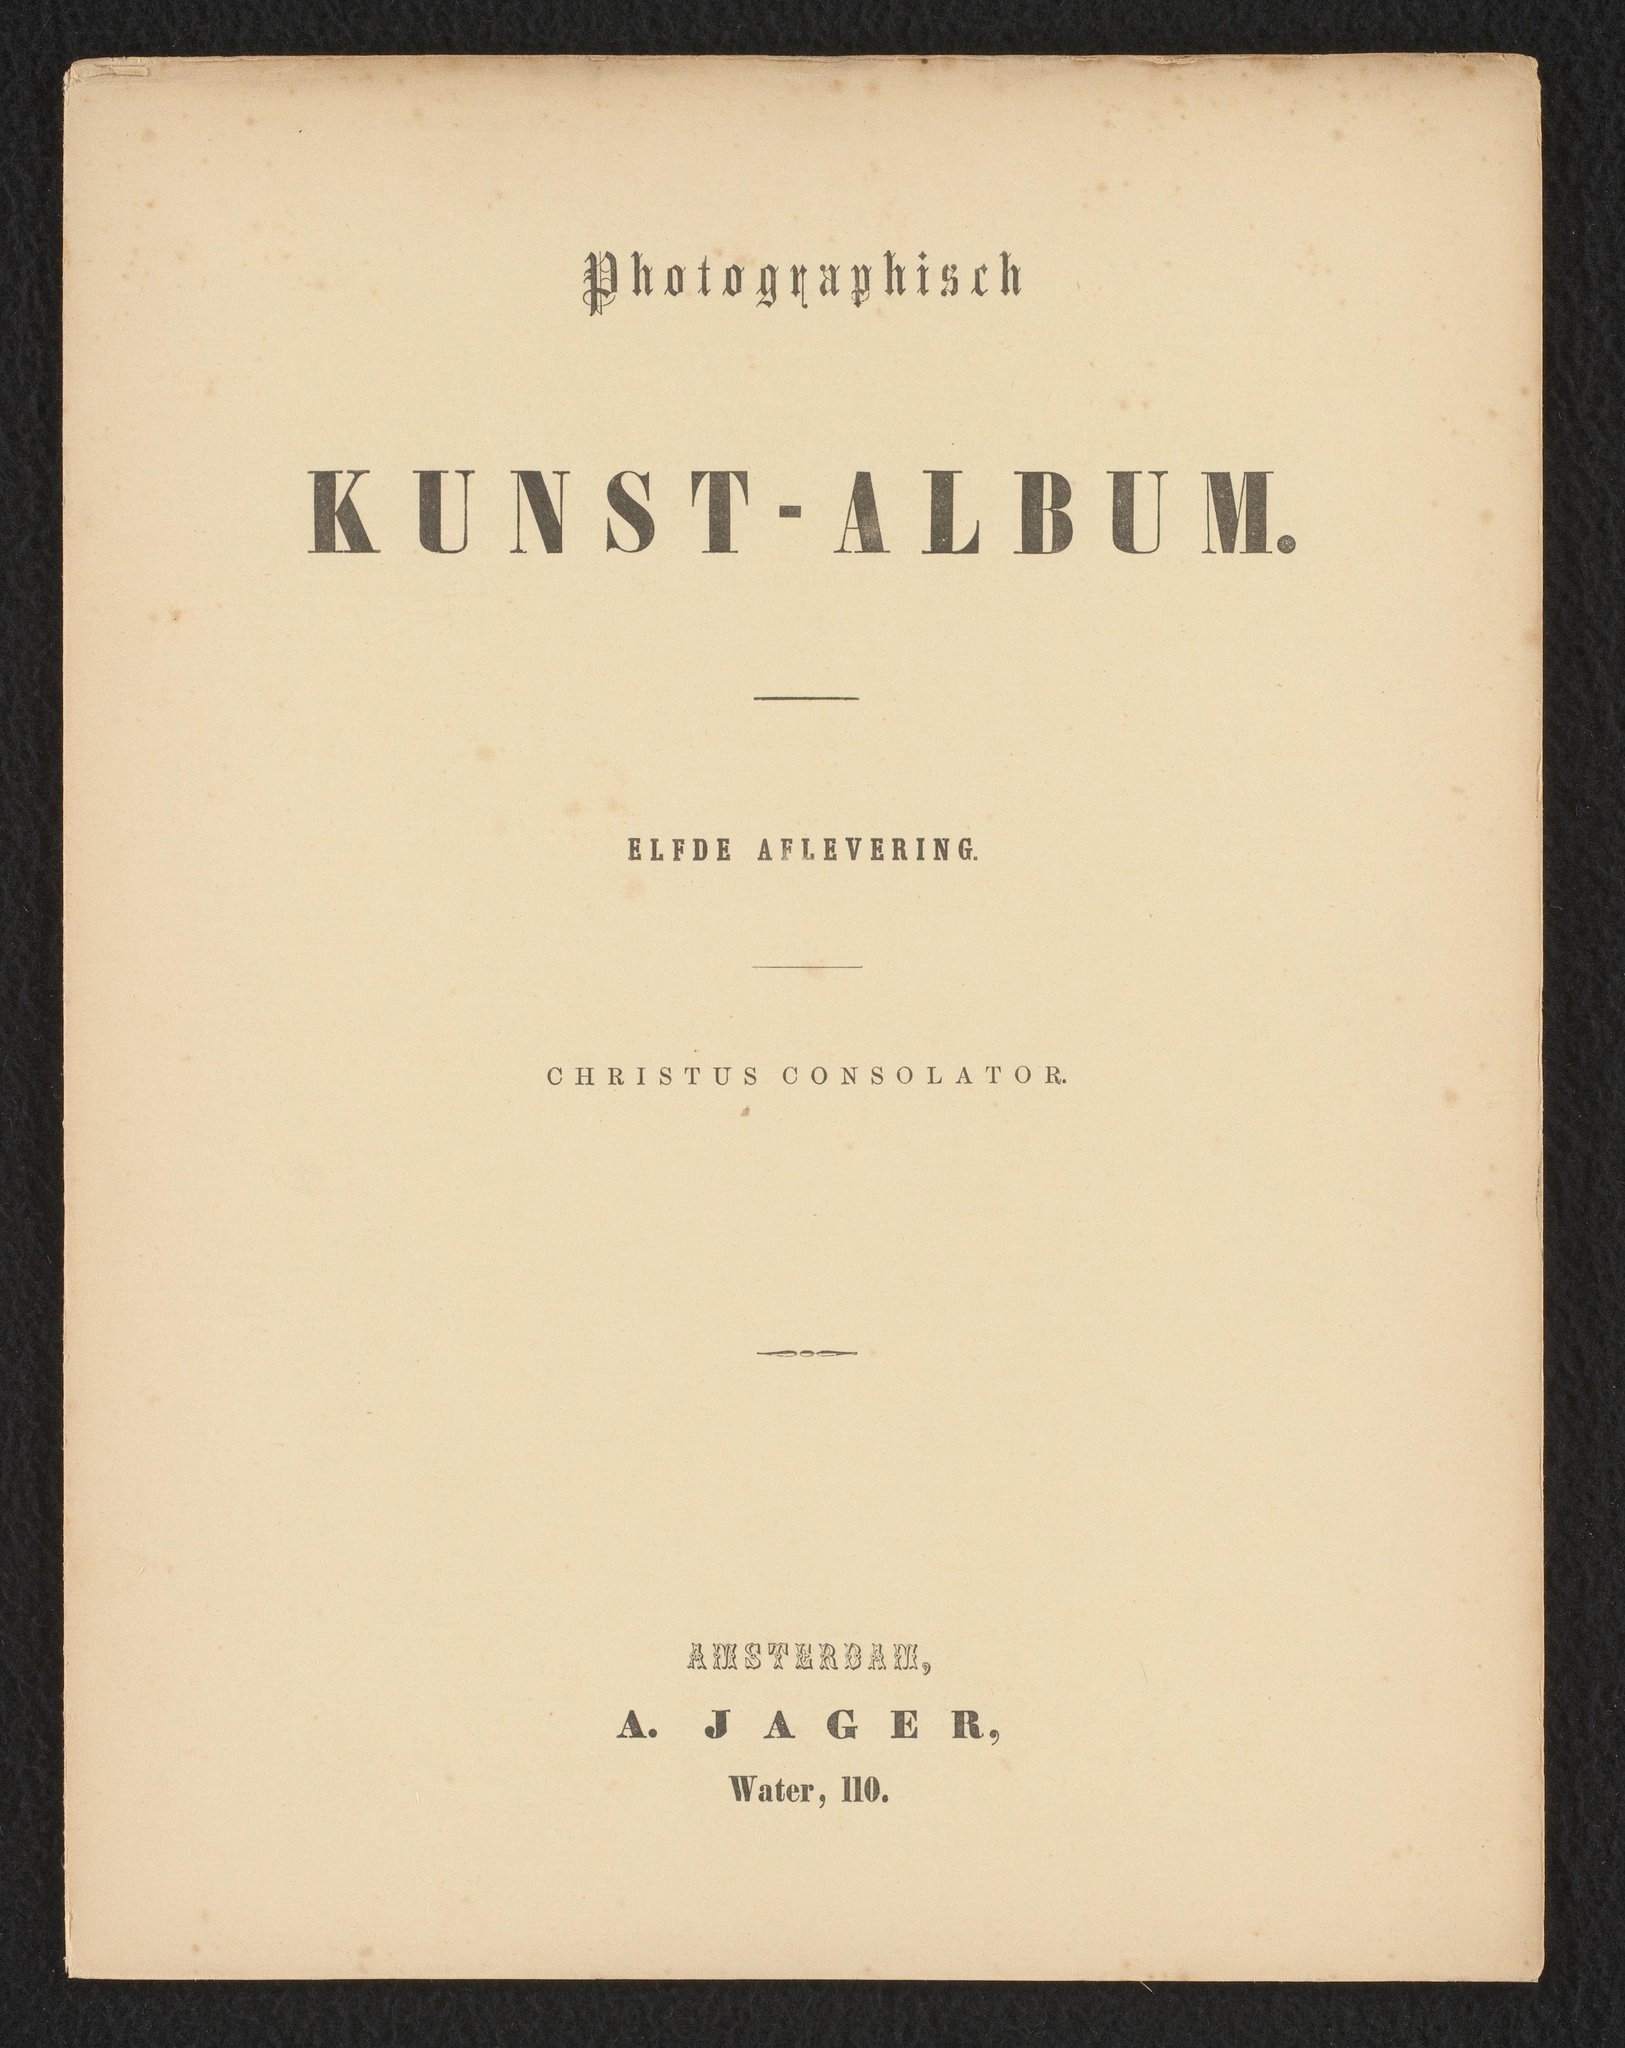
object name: wrapper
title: Omslag voor een fotoreproductie van het schilderij Christus Consolator naar A. Scheffer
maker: andries jager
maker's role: publisher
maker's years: 1825-1905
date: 1860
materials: paper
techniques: printing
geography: amsterdam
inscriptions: inscription: ‘CHRISTUS CONSOLATOR. / NAAR EENE SCHILDERIJ/ VAN/ A. SCHEFFER.’, address: ‘AMSTERDAM,/ A. JAGER,/ Water, 110.’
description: Deze omslag maakt deel uit van een omslag met twaalf fotoreproducties.